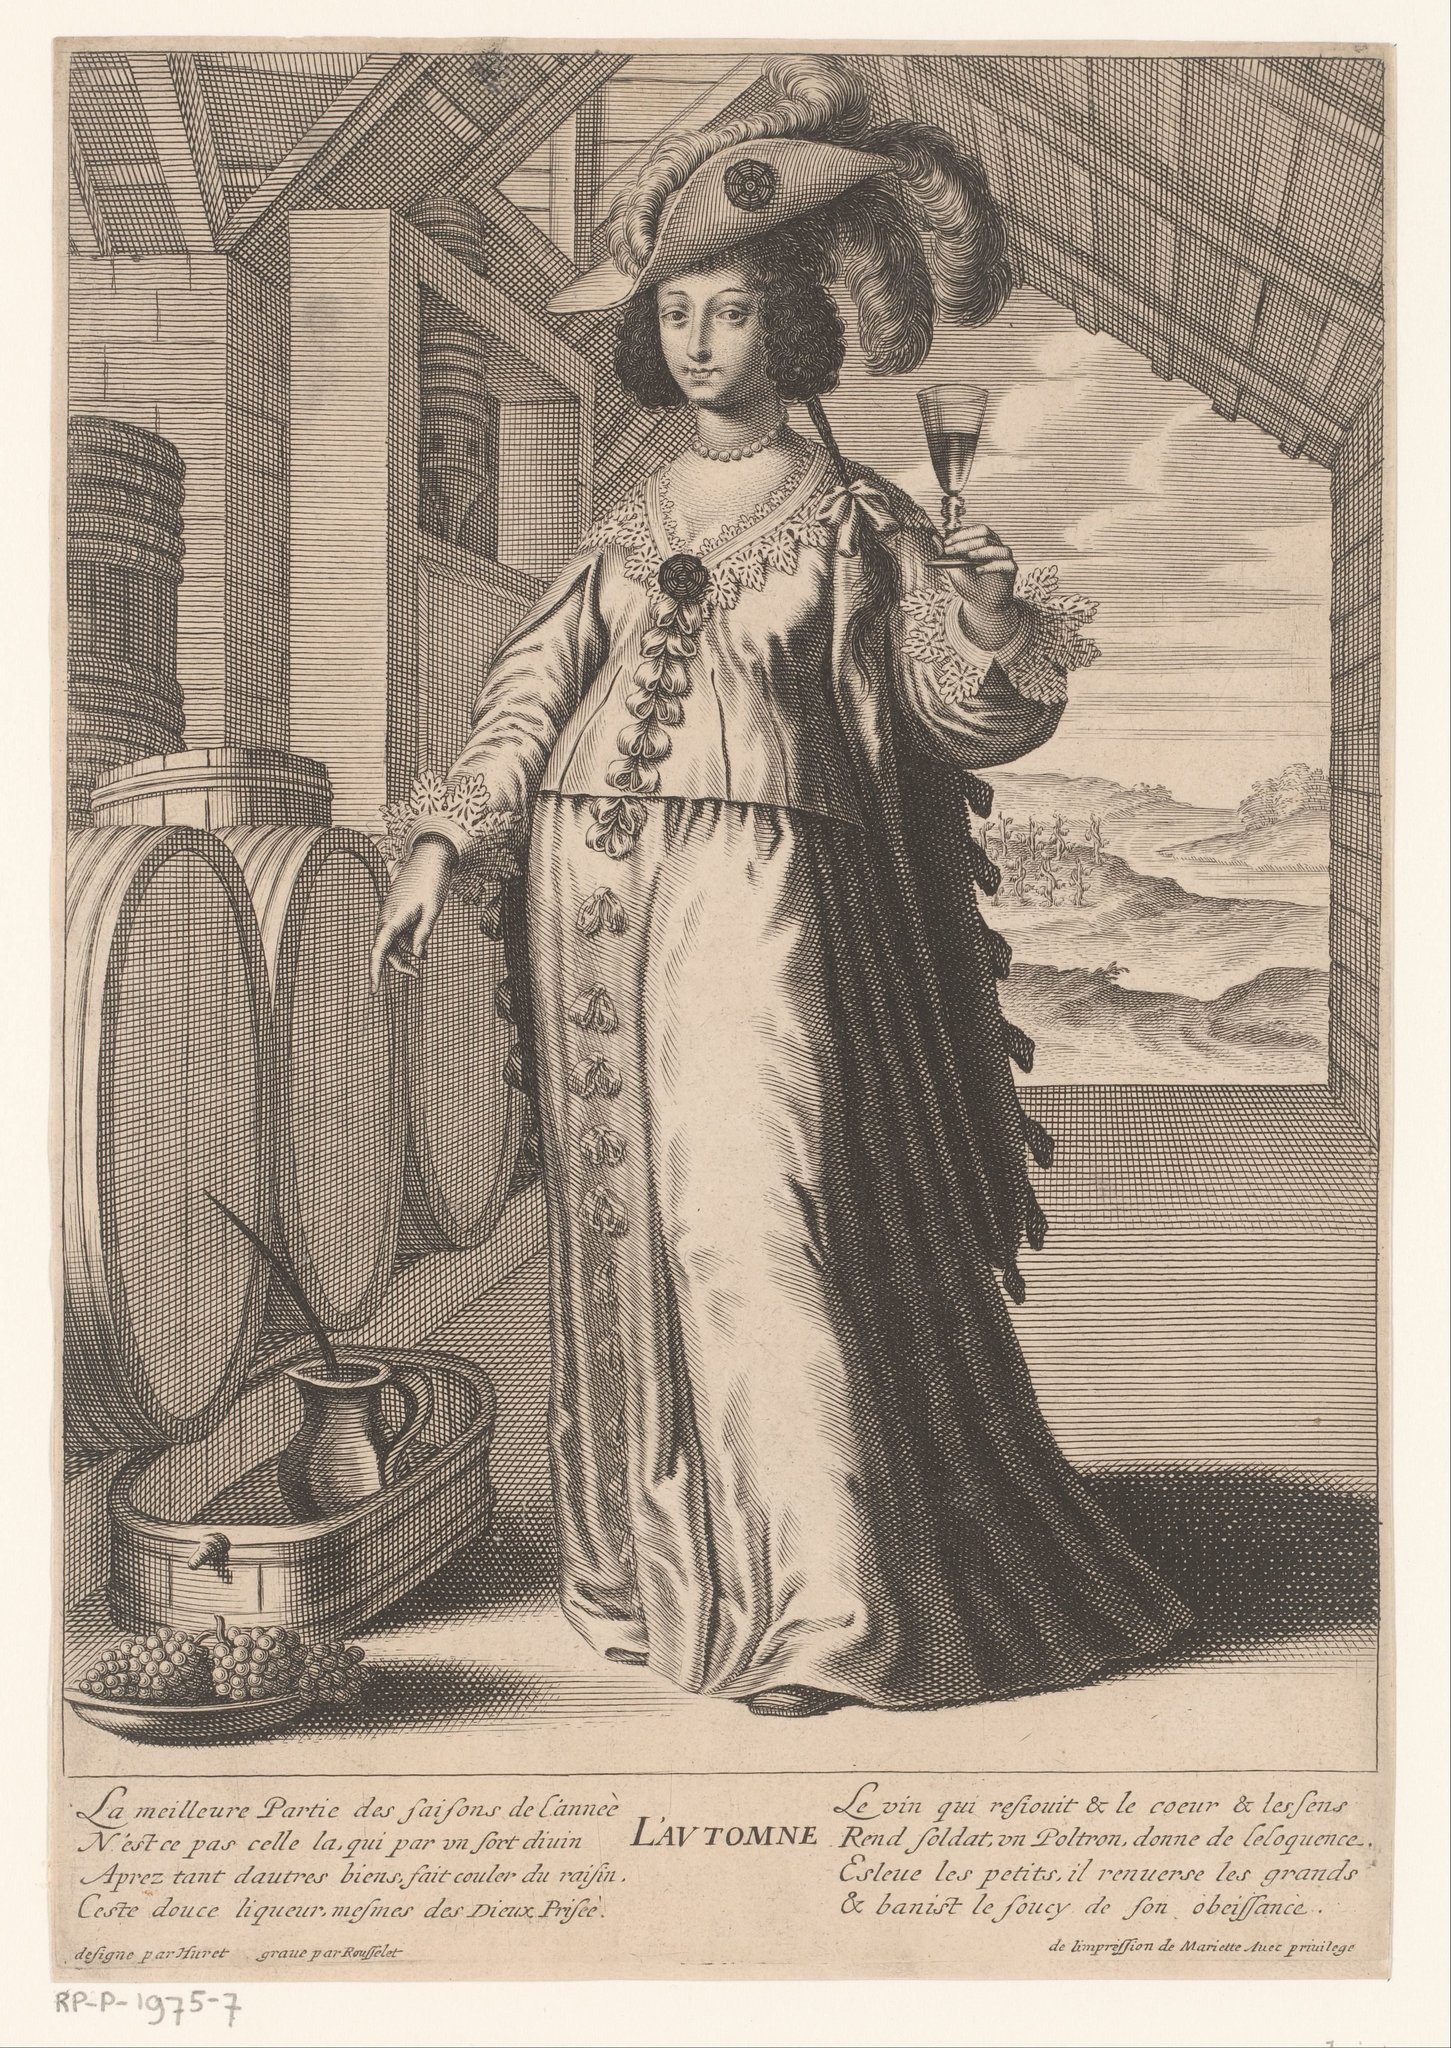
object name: print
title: Vier seizoenen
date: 1620-1657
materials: paper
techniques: engraving, etching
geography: france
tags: wine production, autumn, fall, 'autumnus'; 'autunno' (ripa)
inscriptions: collector's mark: Lugt 2760, collector's mark: Lugt 2228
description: Prent maakt deel uit van een ongenummerde serie van vier prenten over de vier seizoenen, waarvan de herfst en de winter door Gilles Rousselet zijn gemaakt en de lente en de zomer door Jean Couvay.